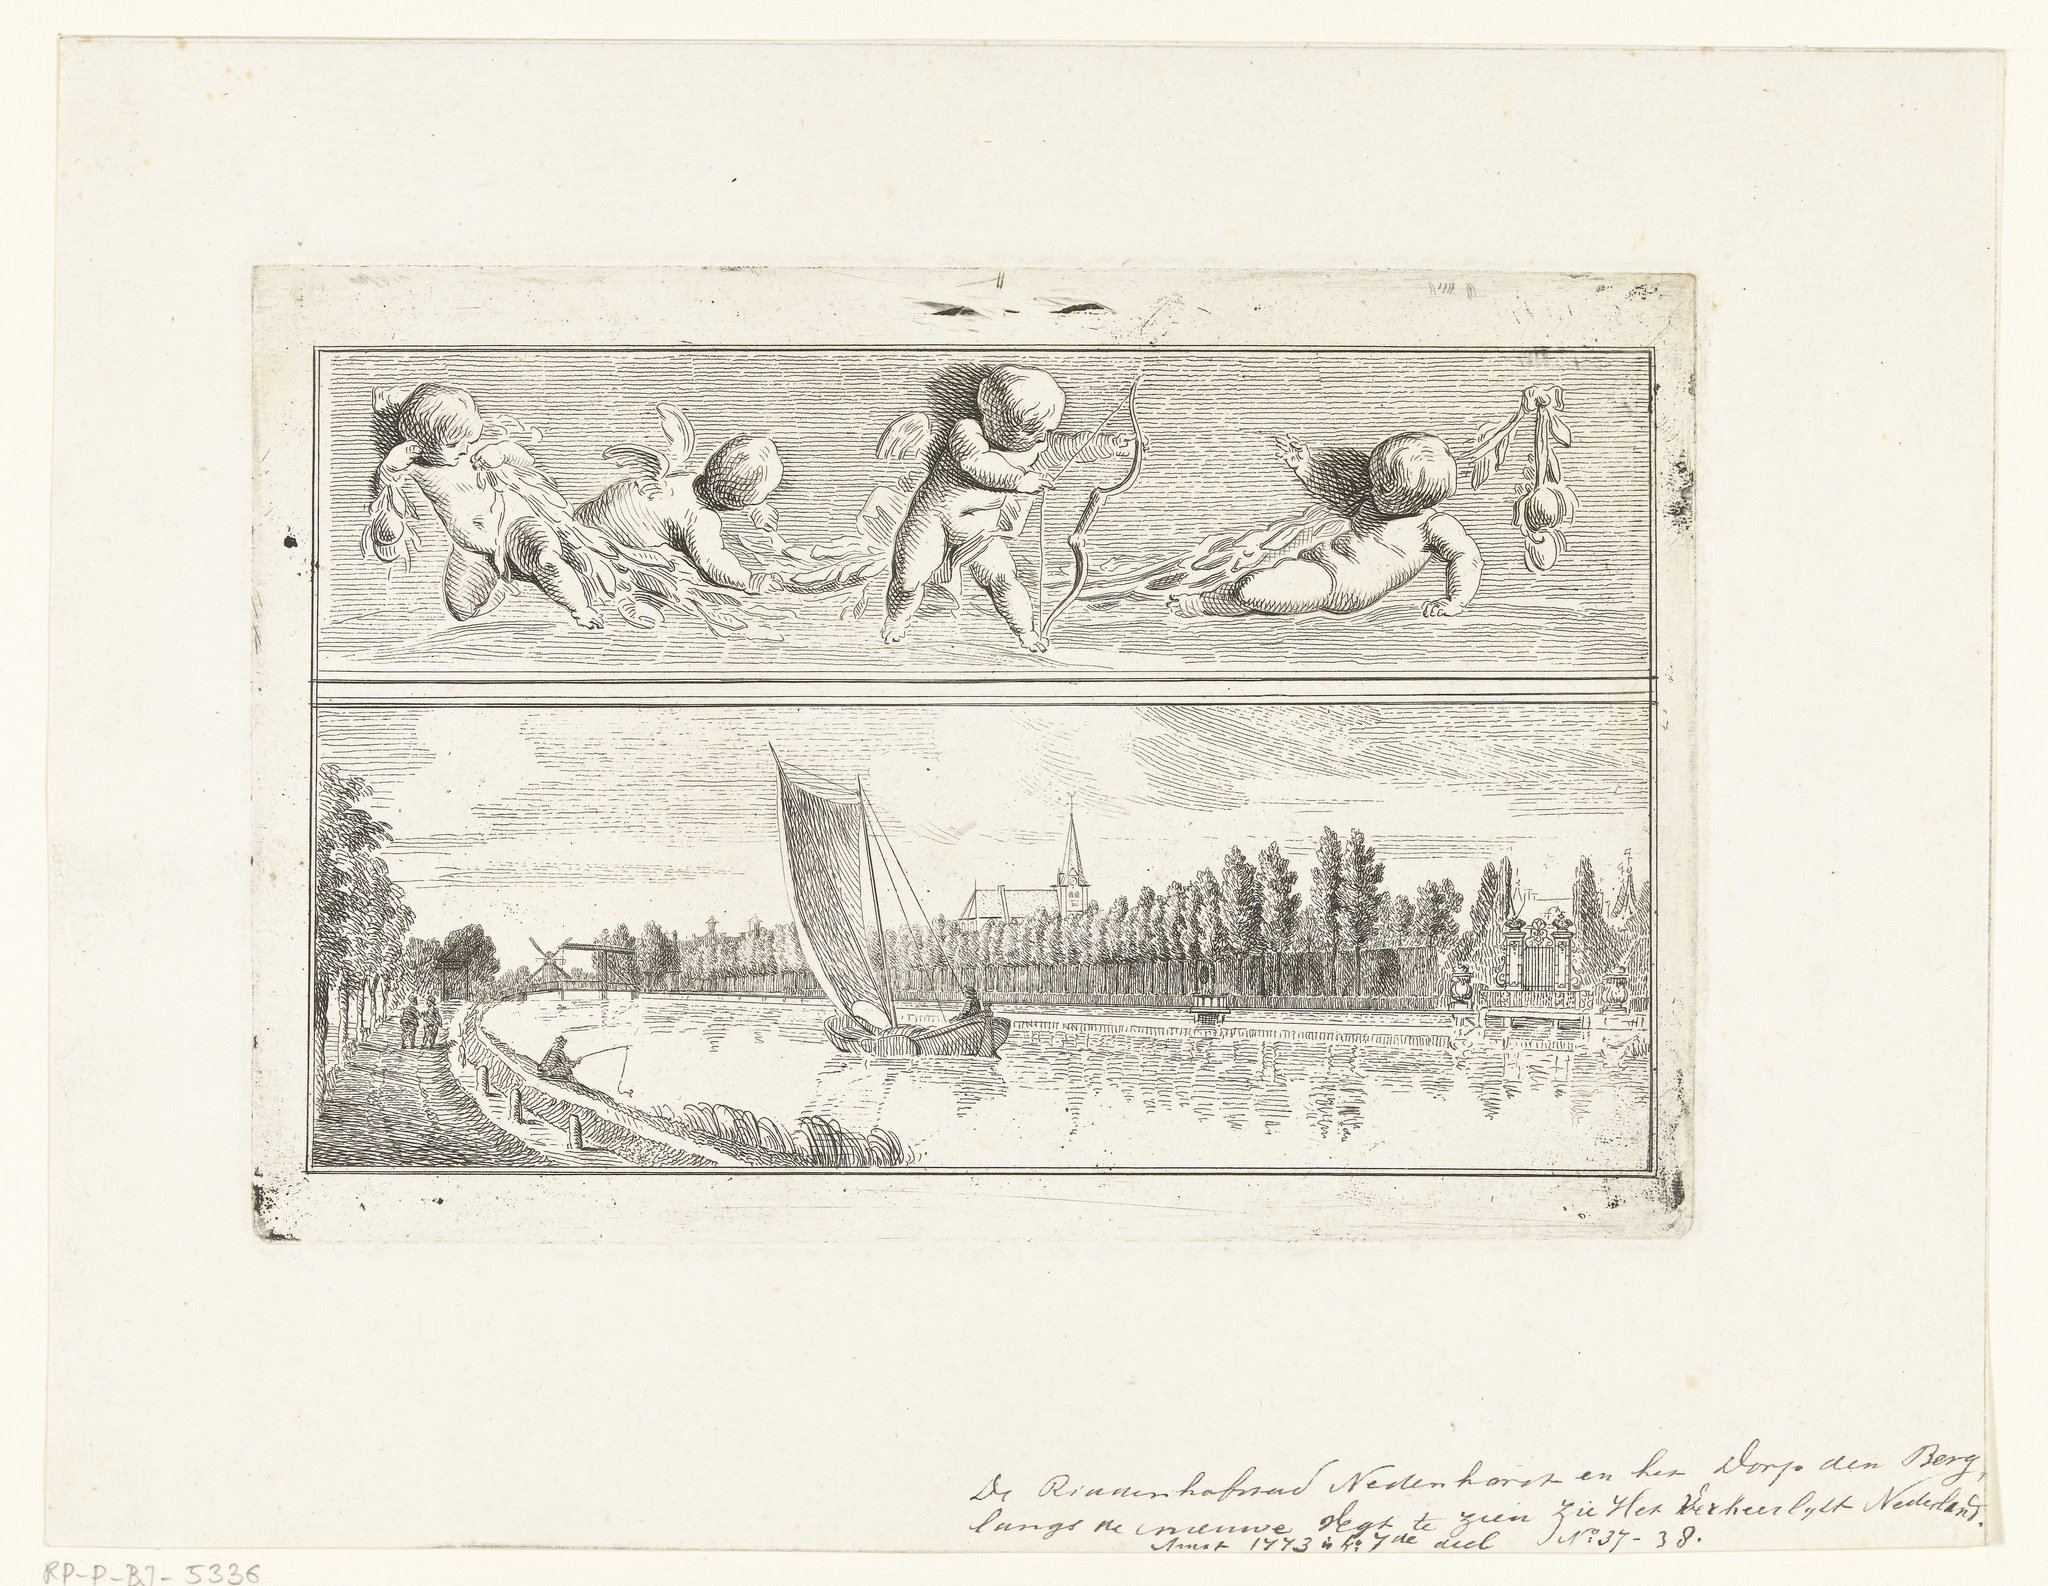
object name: print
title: Fries met putti en gezicht op Nederhorst den Berg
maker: jacobus buys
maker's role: draughtsman, print maker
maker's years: 1724-1801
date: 1740-1801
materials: paper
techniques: etching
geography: amsterdam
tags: river, cupids: 'amores', 'amoretti', 'putti', bridge in village across river, canal, etc., nederhorst den berg, vecht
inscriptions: collector's mark: Lugt 240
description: Een fries met vier spelende putti, de een heeft een boog in zijn hand. Onder het fries een gezicht op de Vecht bij Nederhorst den Berg. Op de vaart een zeilschip, aan de oever zit een man te vissen. Aan de overkant van het water is de statige poort van een buitenplaats te zien.